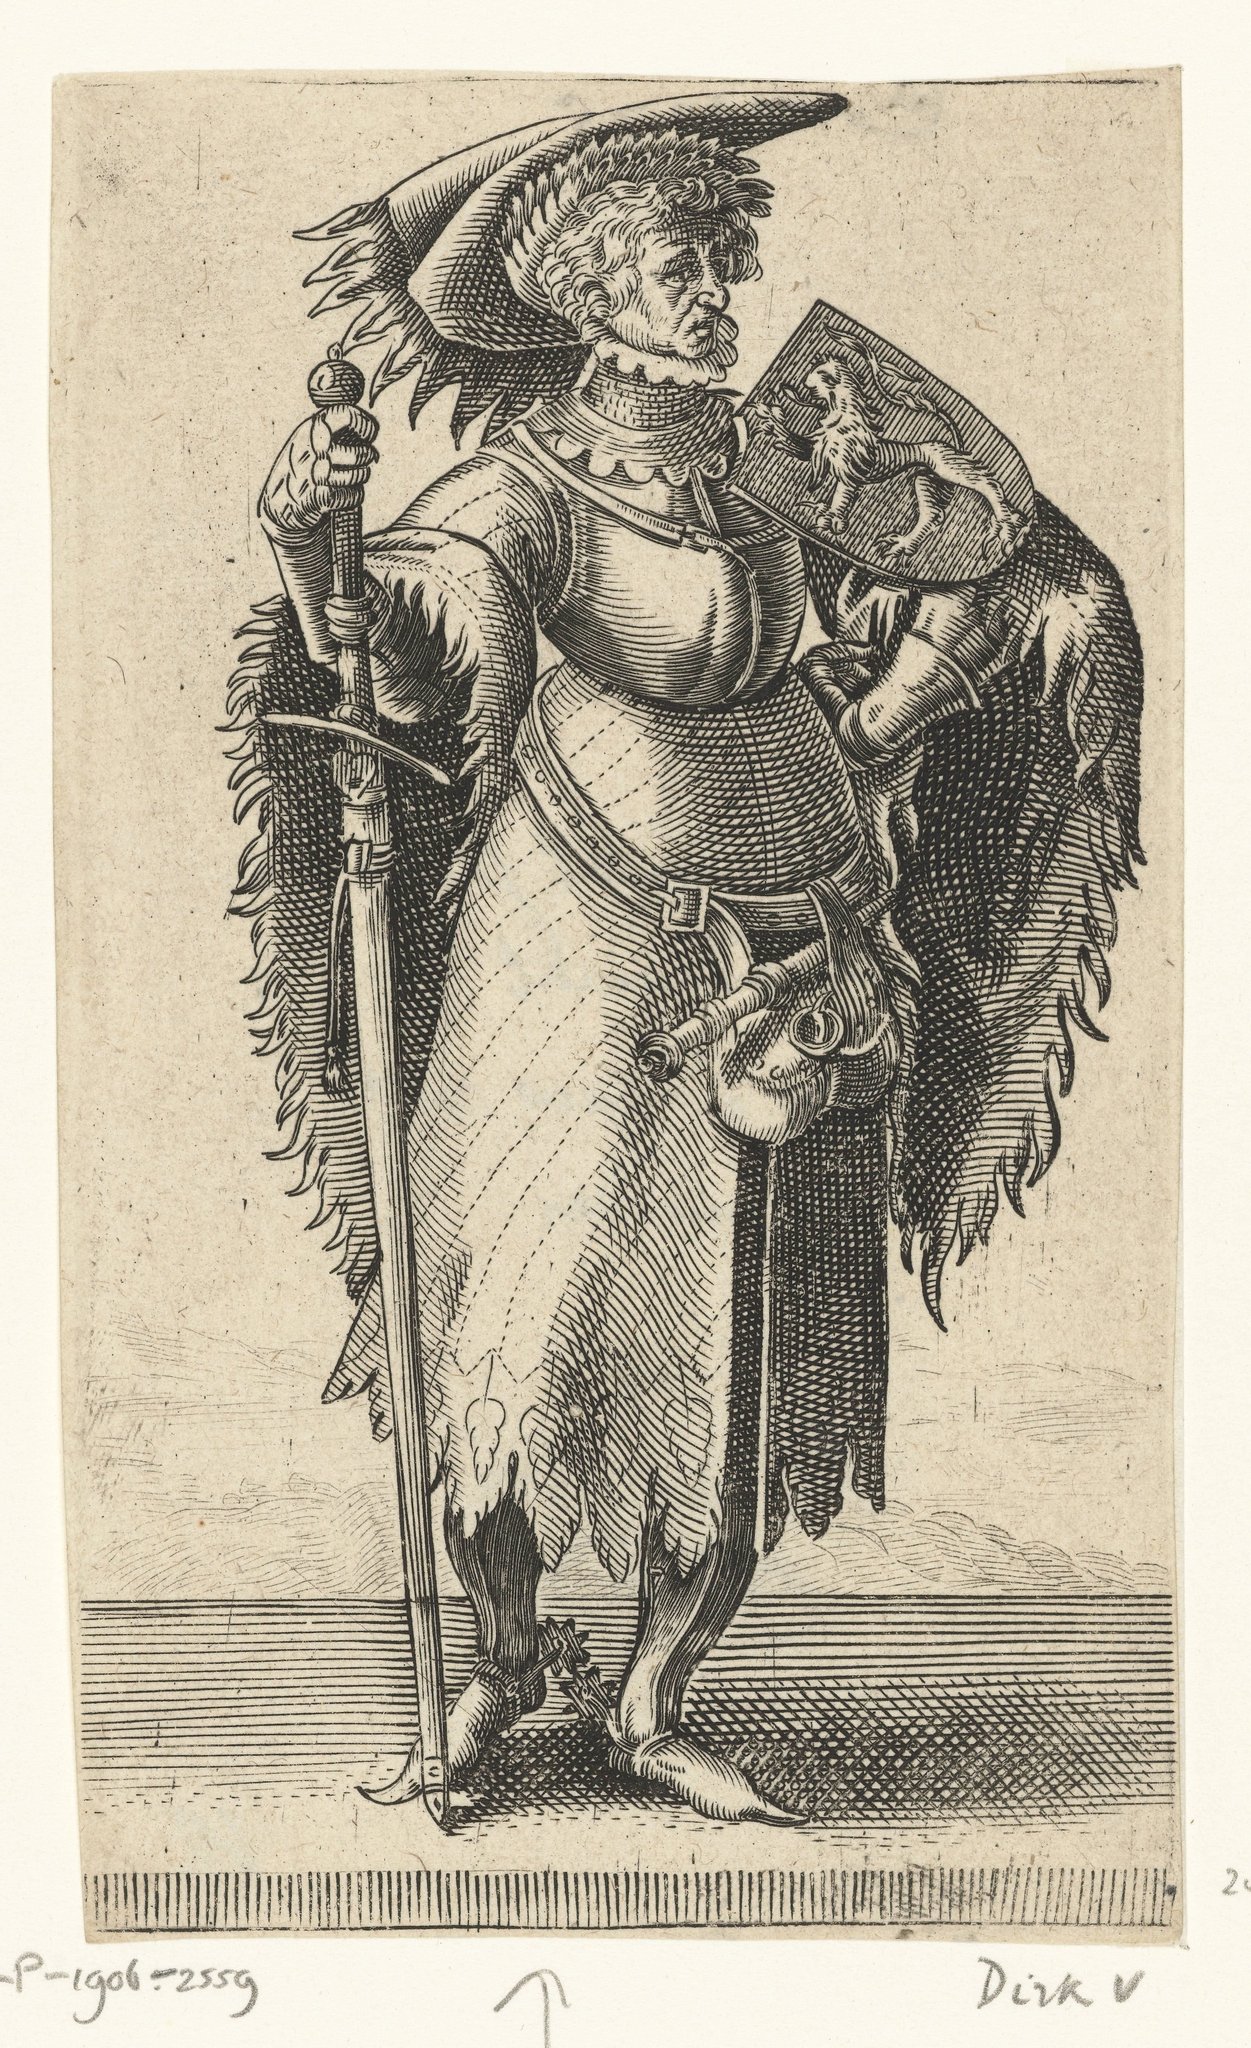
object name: print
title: Portret van Dirk V, graaf van Holland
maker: adriaen matham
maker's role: draughtsman, print maker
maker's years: 1599-1660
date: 1620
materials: paper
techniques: engraving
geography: haarlem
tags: earl, nobility and patriciate; chivalry, knighthood, county of holland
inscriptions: number: ‘1075’, collector's mark: Lugt 2228, name: ‘dirk graaf floris/ soon 7de graaf/ [...] was verdreve met/ zijn moeder’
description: Portret van Dirk V, graaf van Holland, staande in een harnas met op zijn schouder het wapen van Holland en in zijn hand een zwaard. Prent uit een serie van 36 prenten met portretten ten voeten uit van graven en gravinnen van Holland.